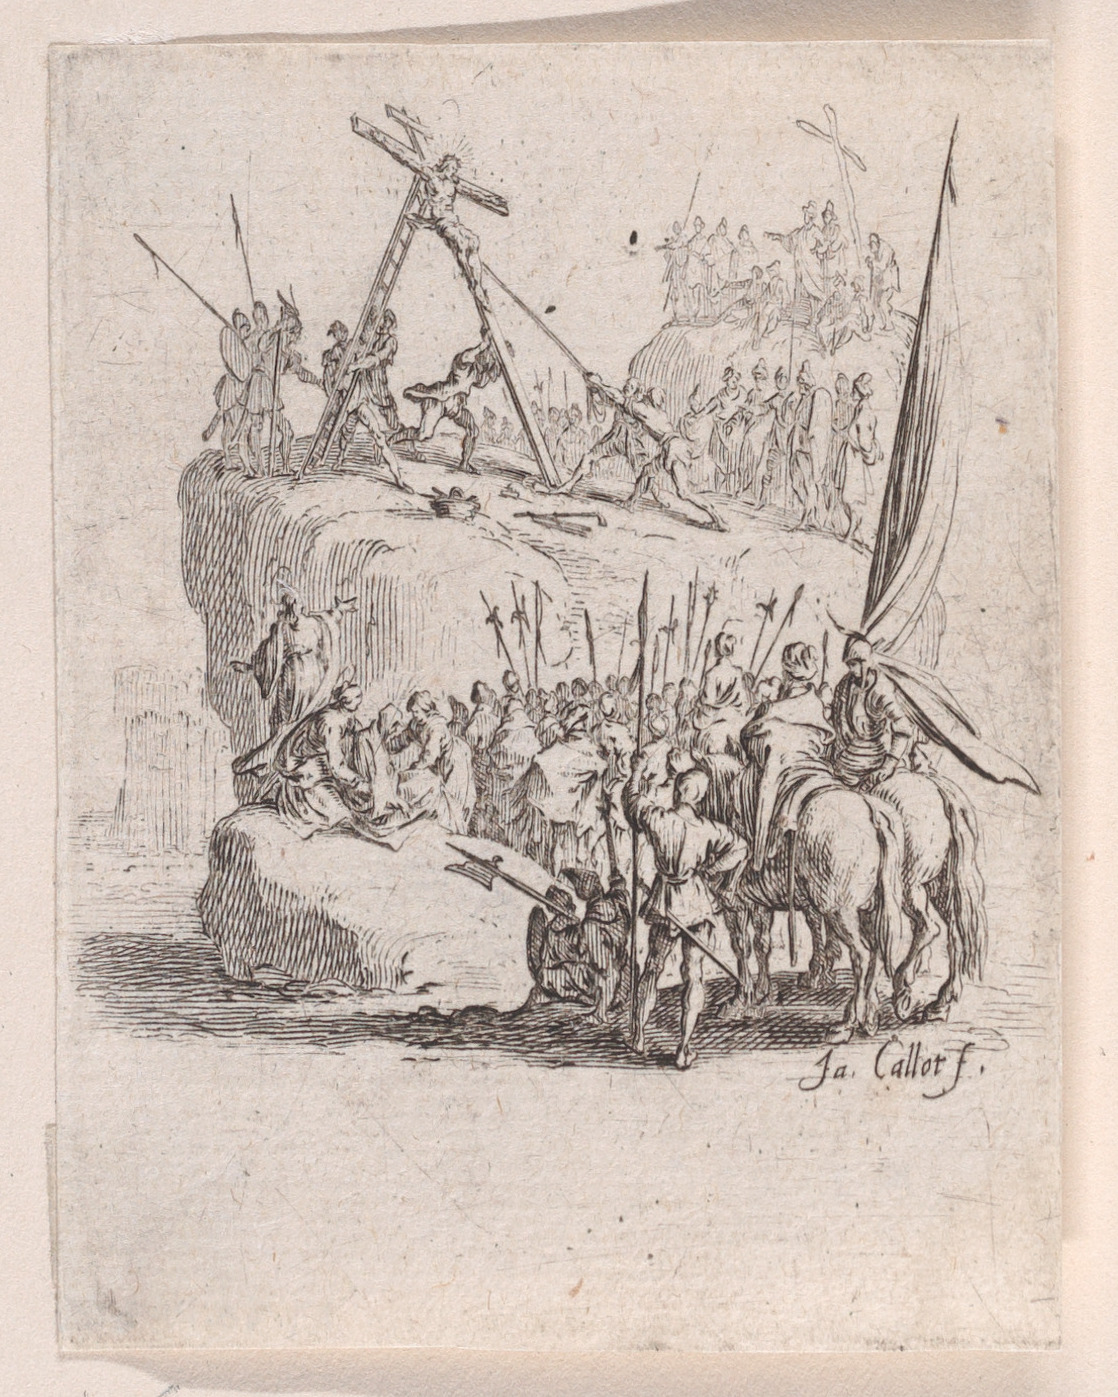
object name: print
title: Le Crucifiement (The Crucifixion), from "La Petite Passion" (The Little Passion)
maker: jacques callot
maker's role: artist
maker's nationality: french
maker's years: 1592-1635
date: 1624-1625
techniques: etching